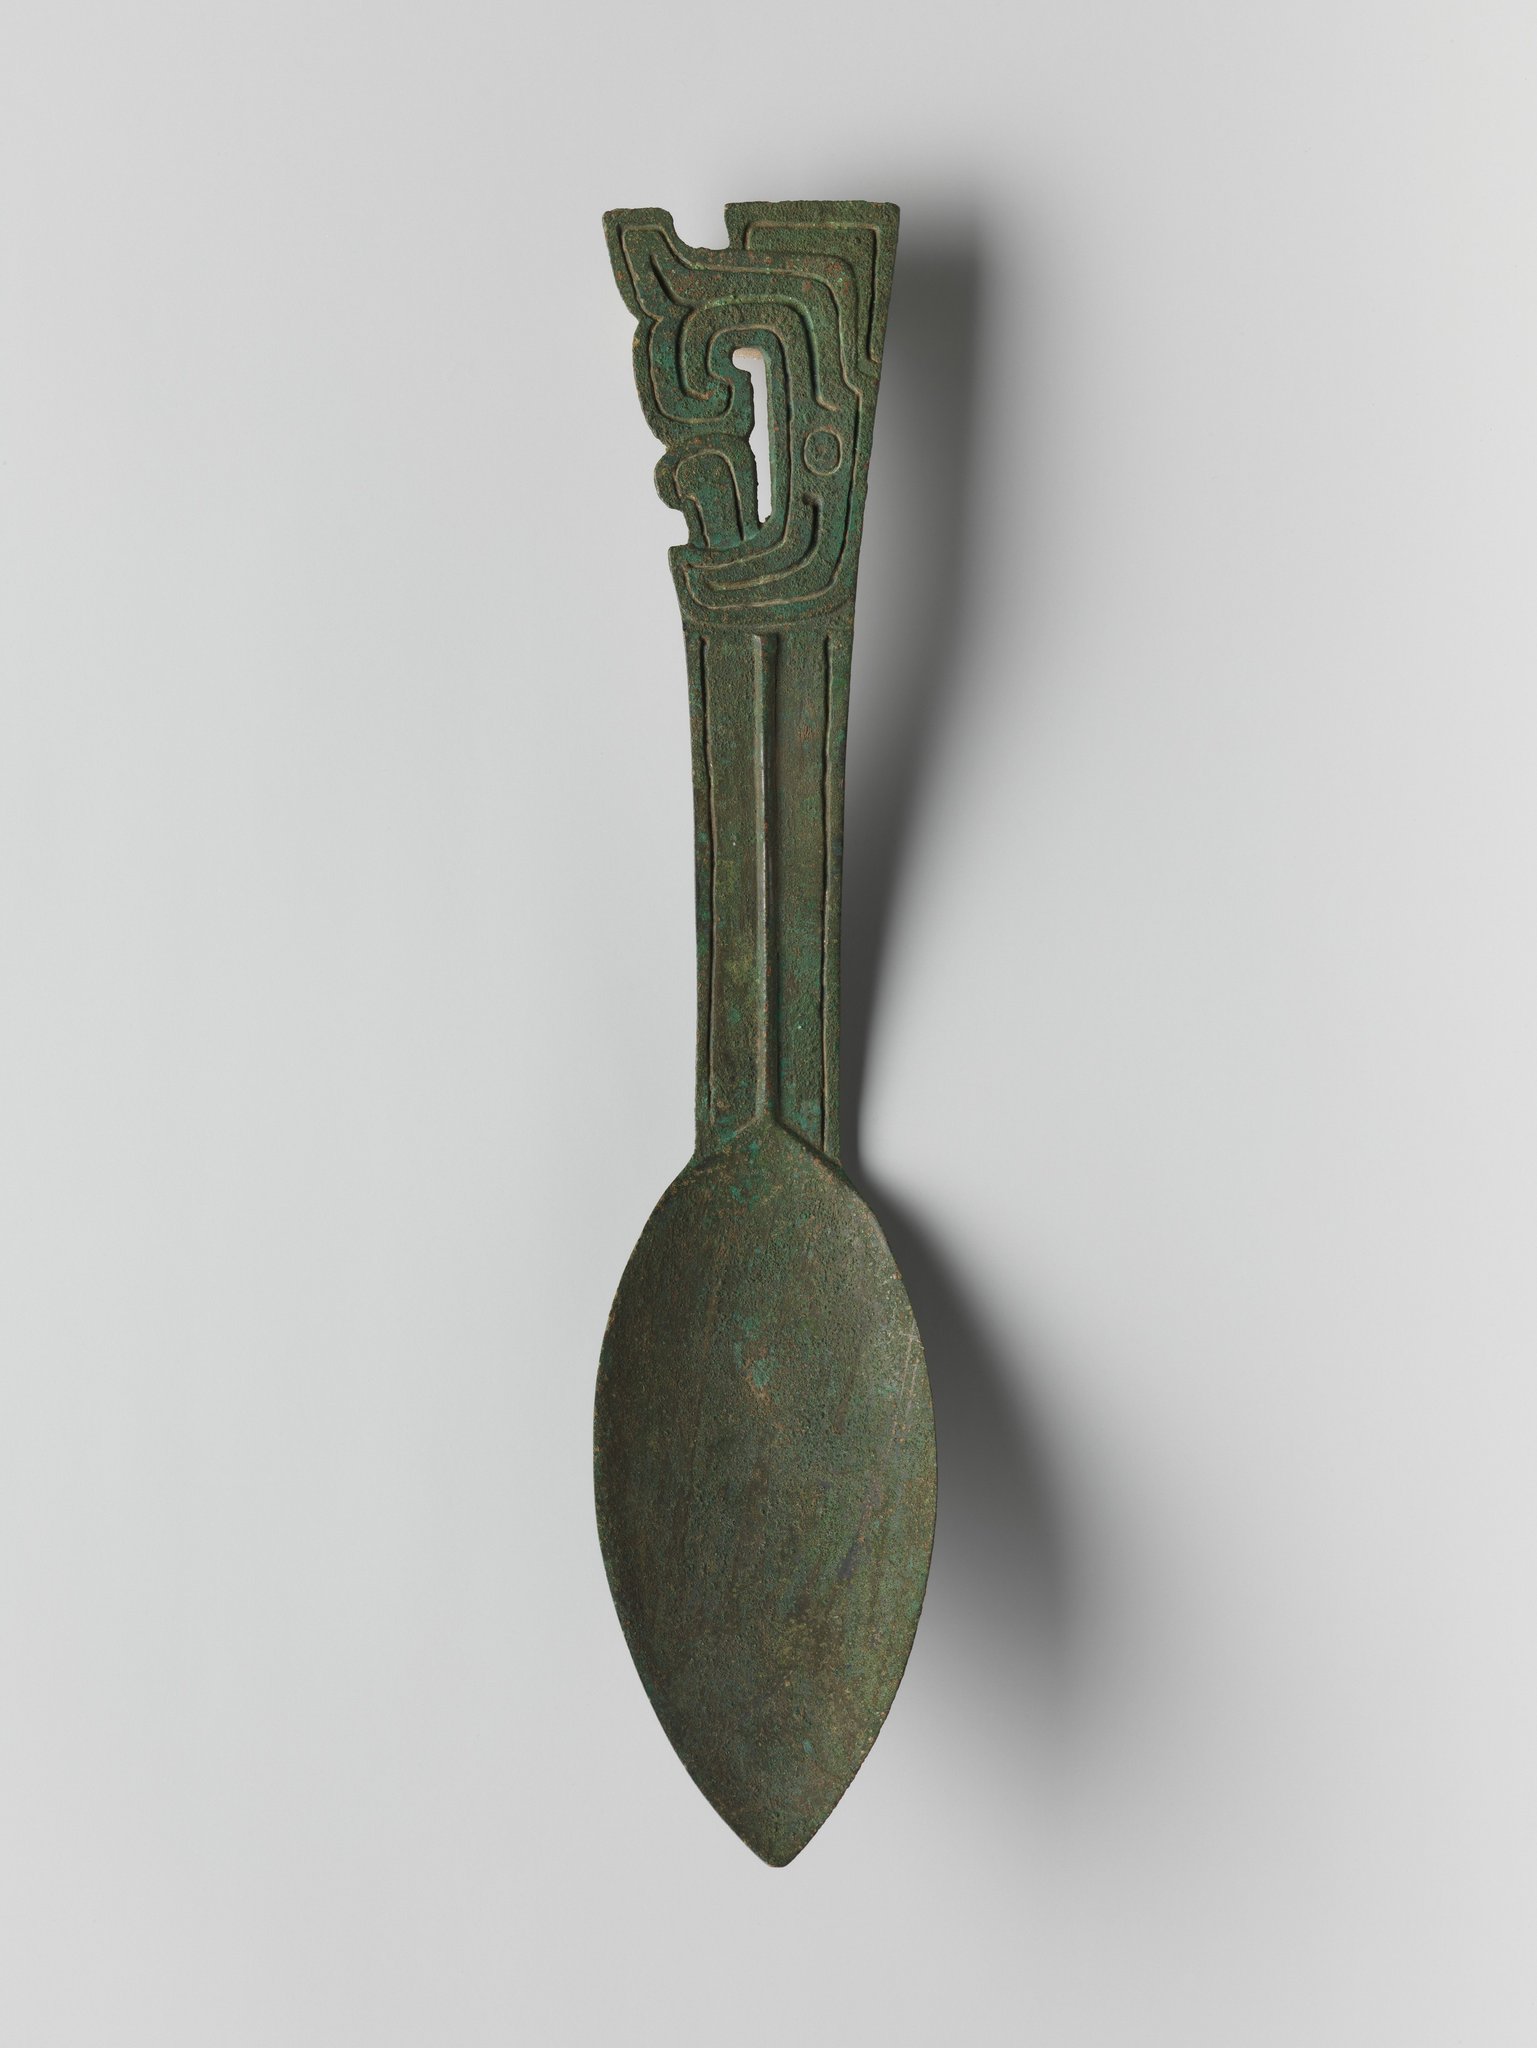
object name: spoon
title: Ritual Spoon (Bi)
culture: chinese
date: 1046-256 BCE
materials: bronze